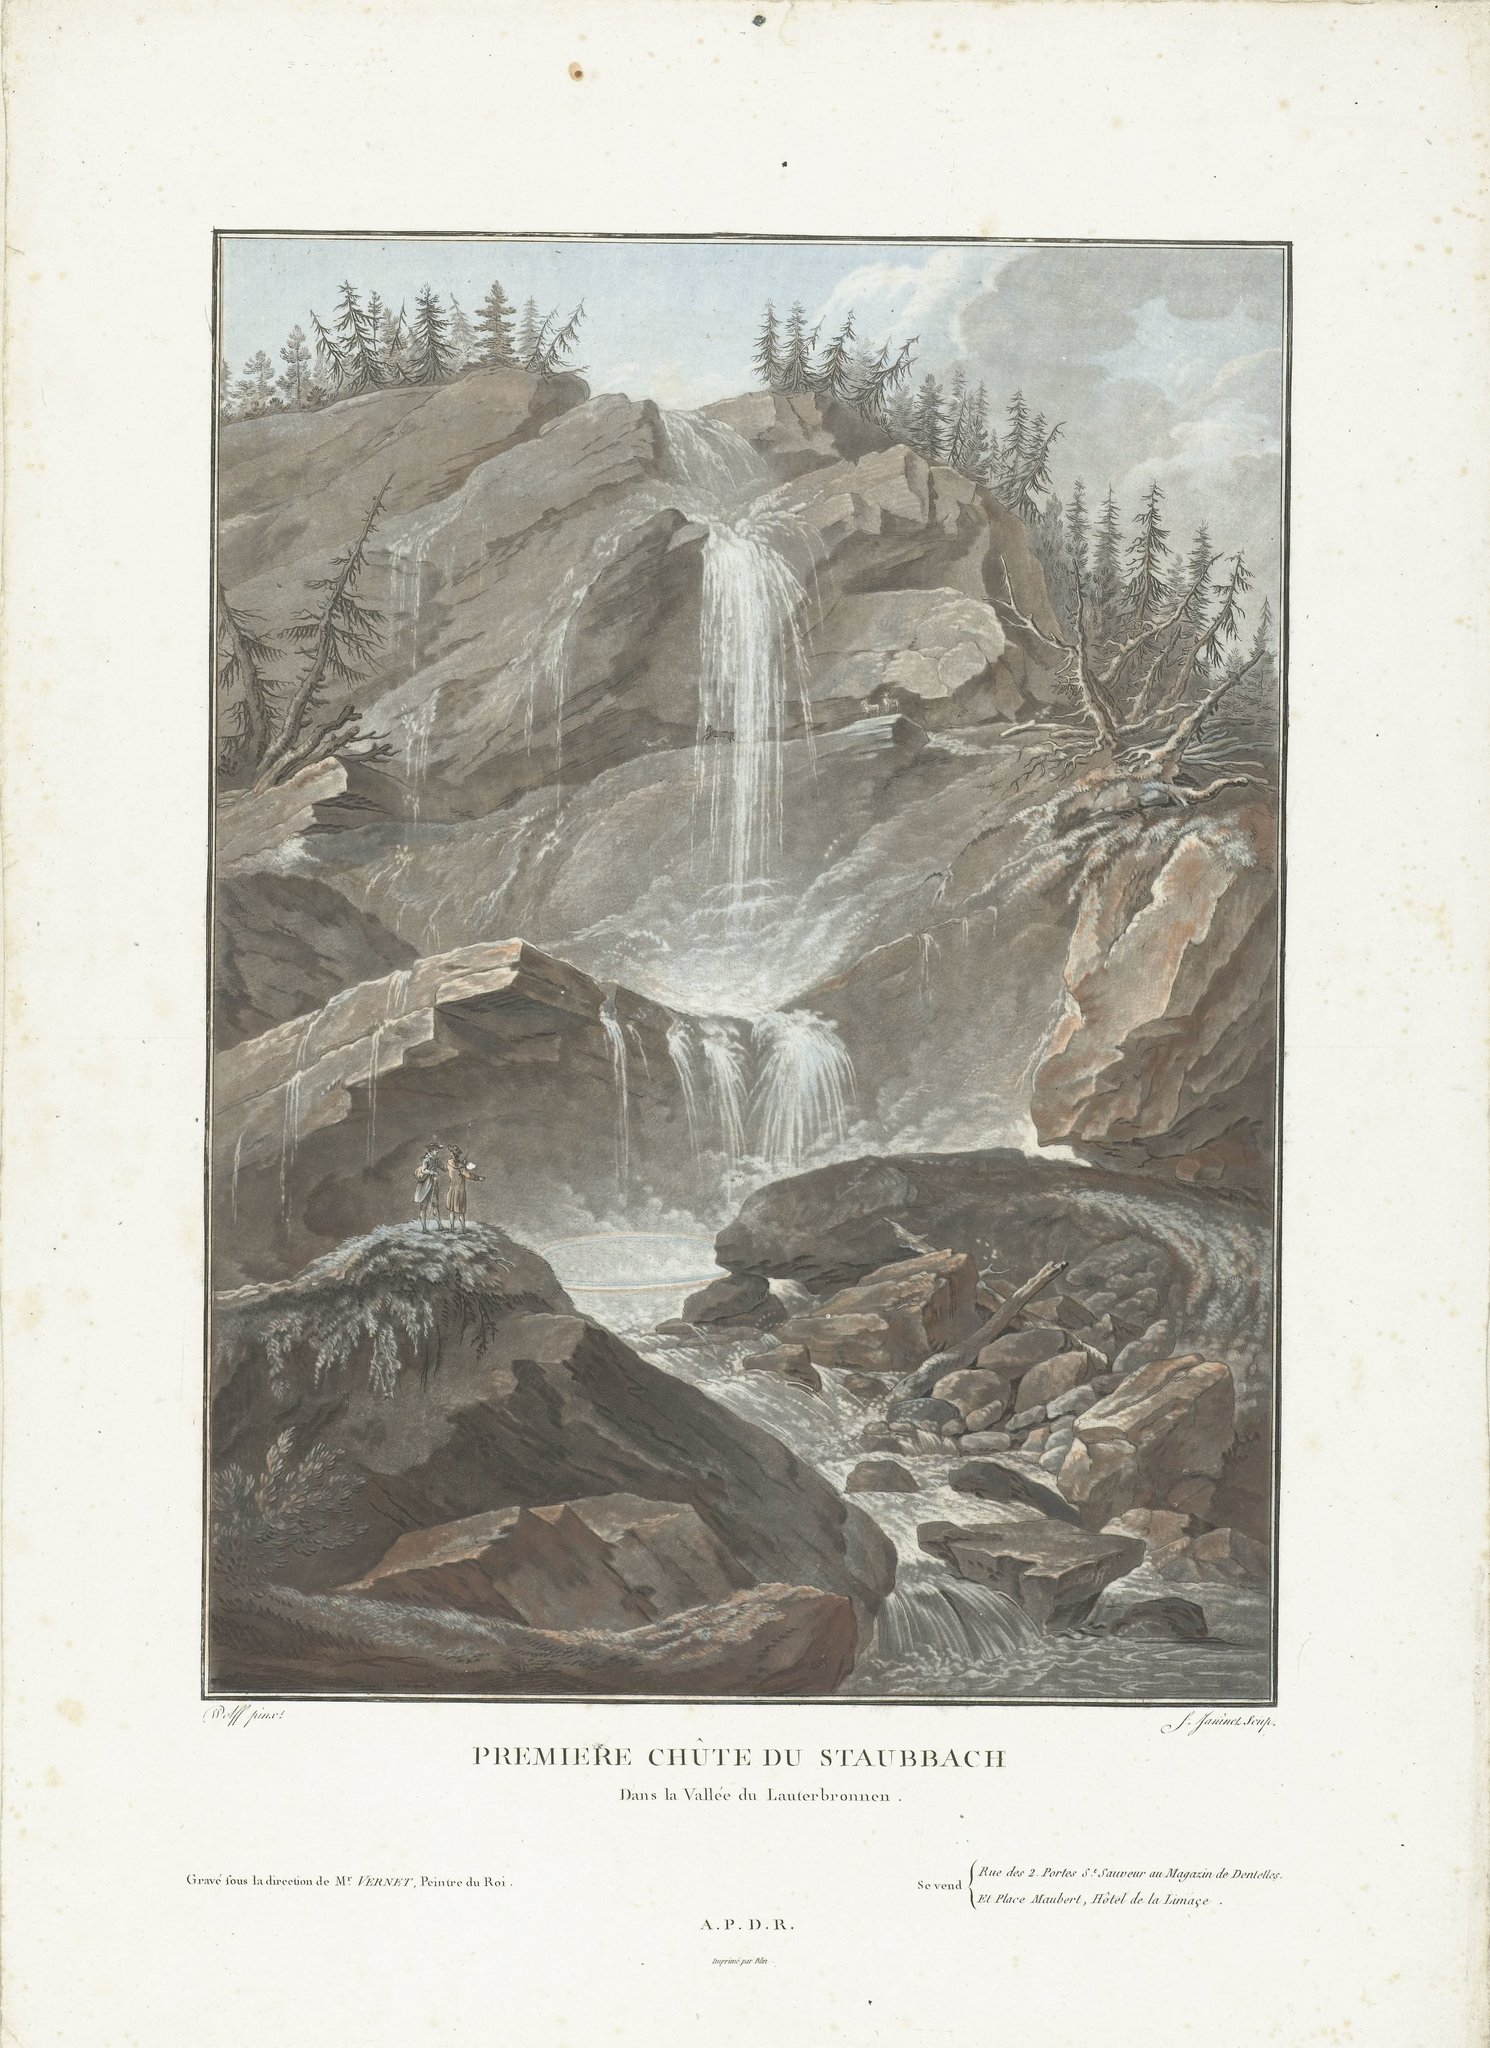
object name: print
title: Waterval van Stabbauch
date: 1772-1785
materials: paper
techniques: etching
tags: waterfall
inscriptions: collector's mark: ‘R. Hentzi’, collector's mark: Lugt 2228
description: De eerste waterval van Staubbach in Lauterbrunnental, Zwitserland. Twee wandelaars staan op een rots.